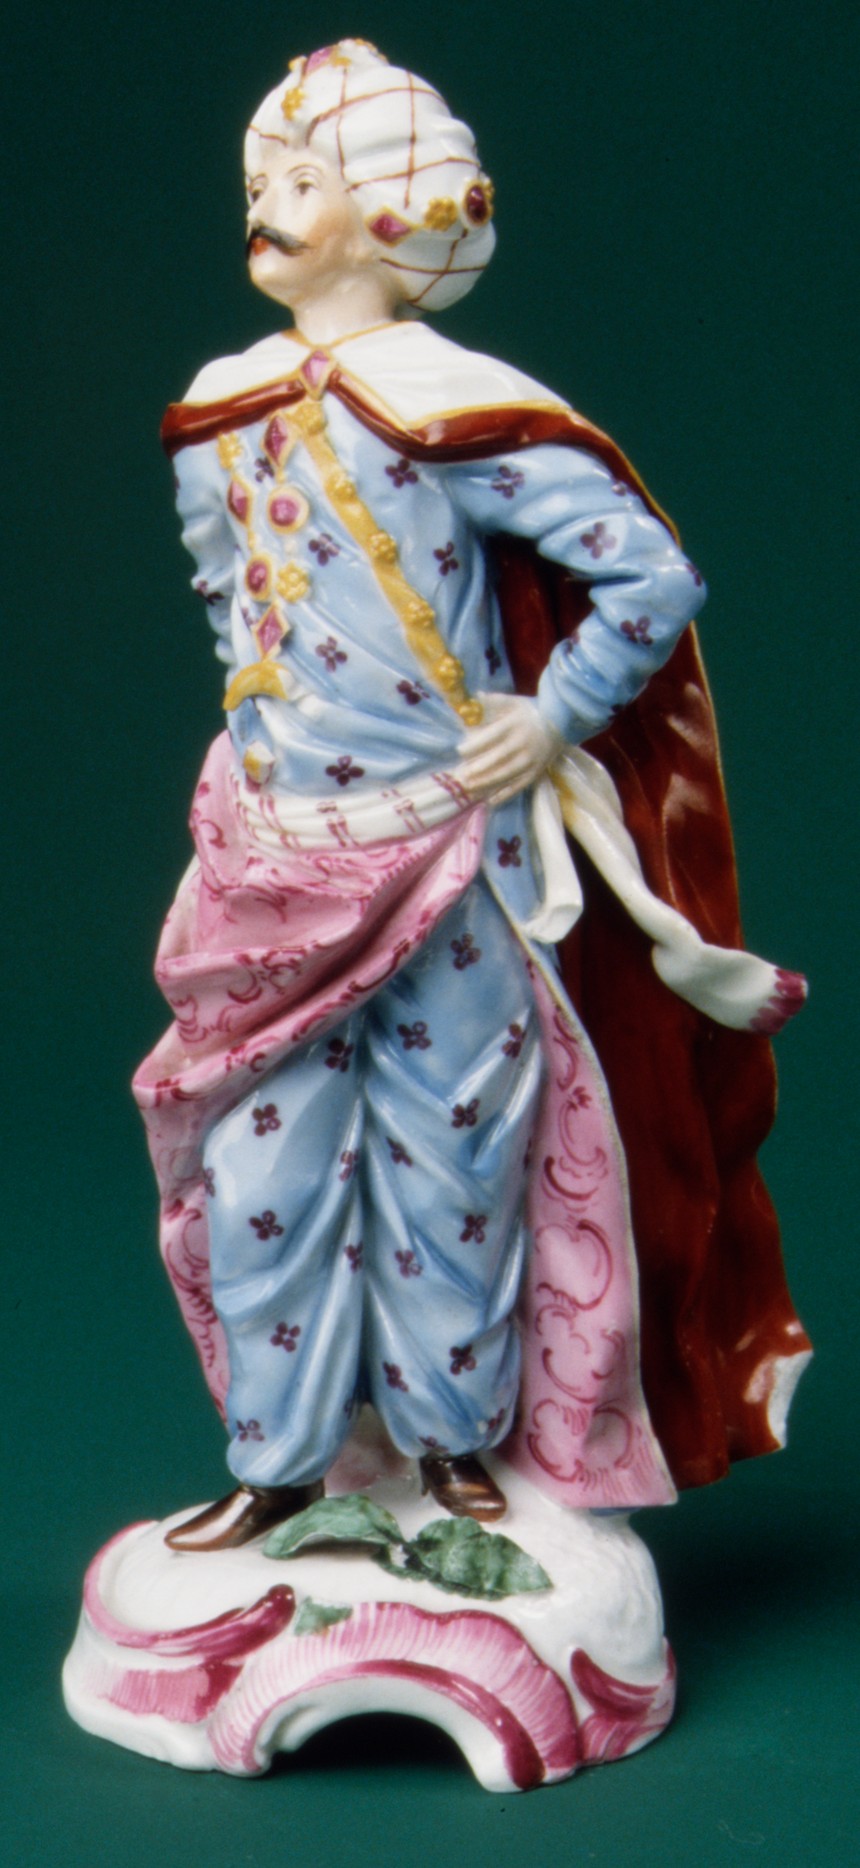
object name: figure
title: Sultan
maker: fulda pottery and porcelain manufactory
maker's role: manufactory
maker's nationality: german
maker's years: 1764-1789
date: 1770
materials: hard paste porcelain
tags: kings,men